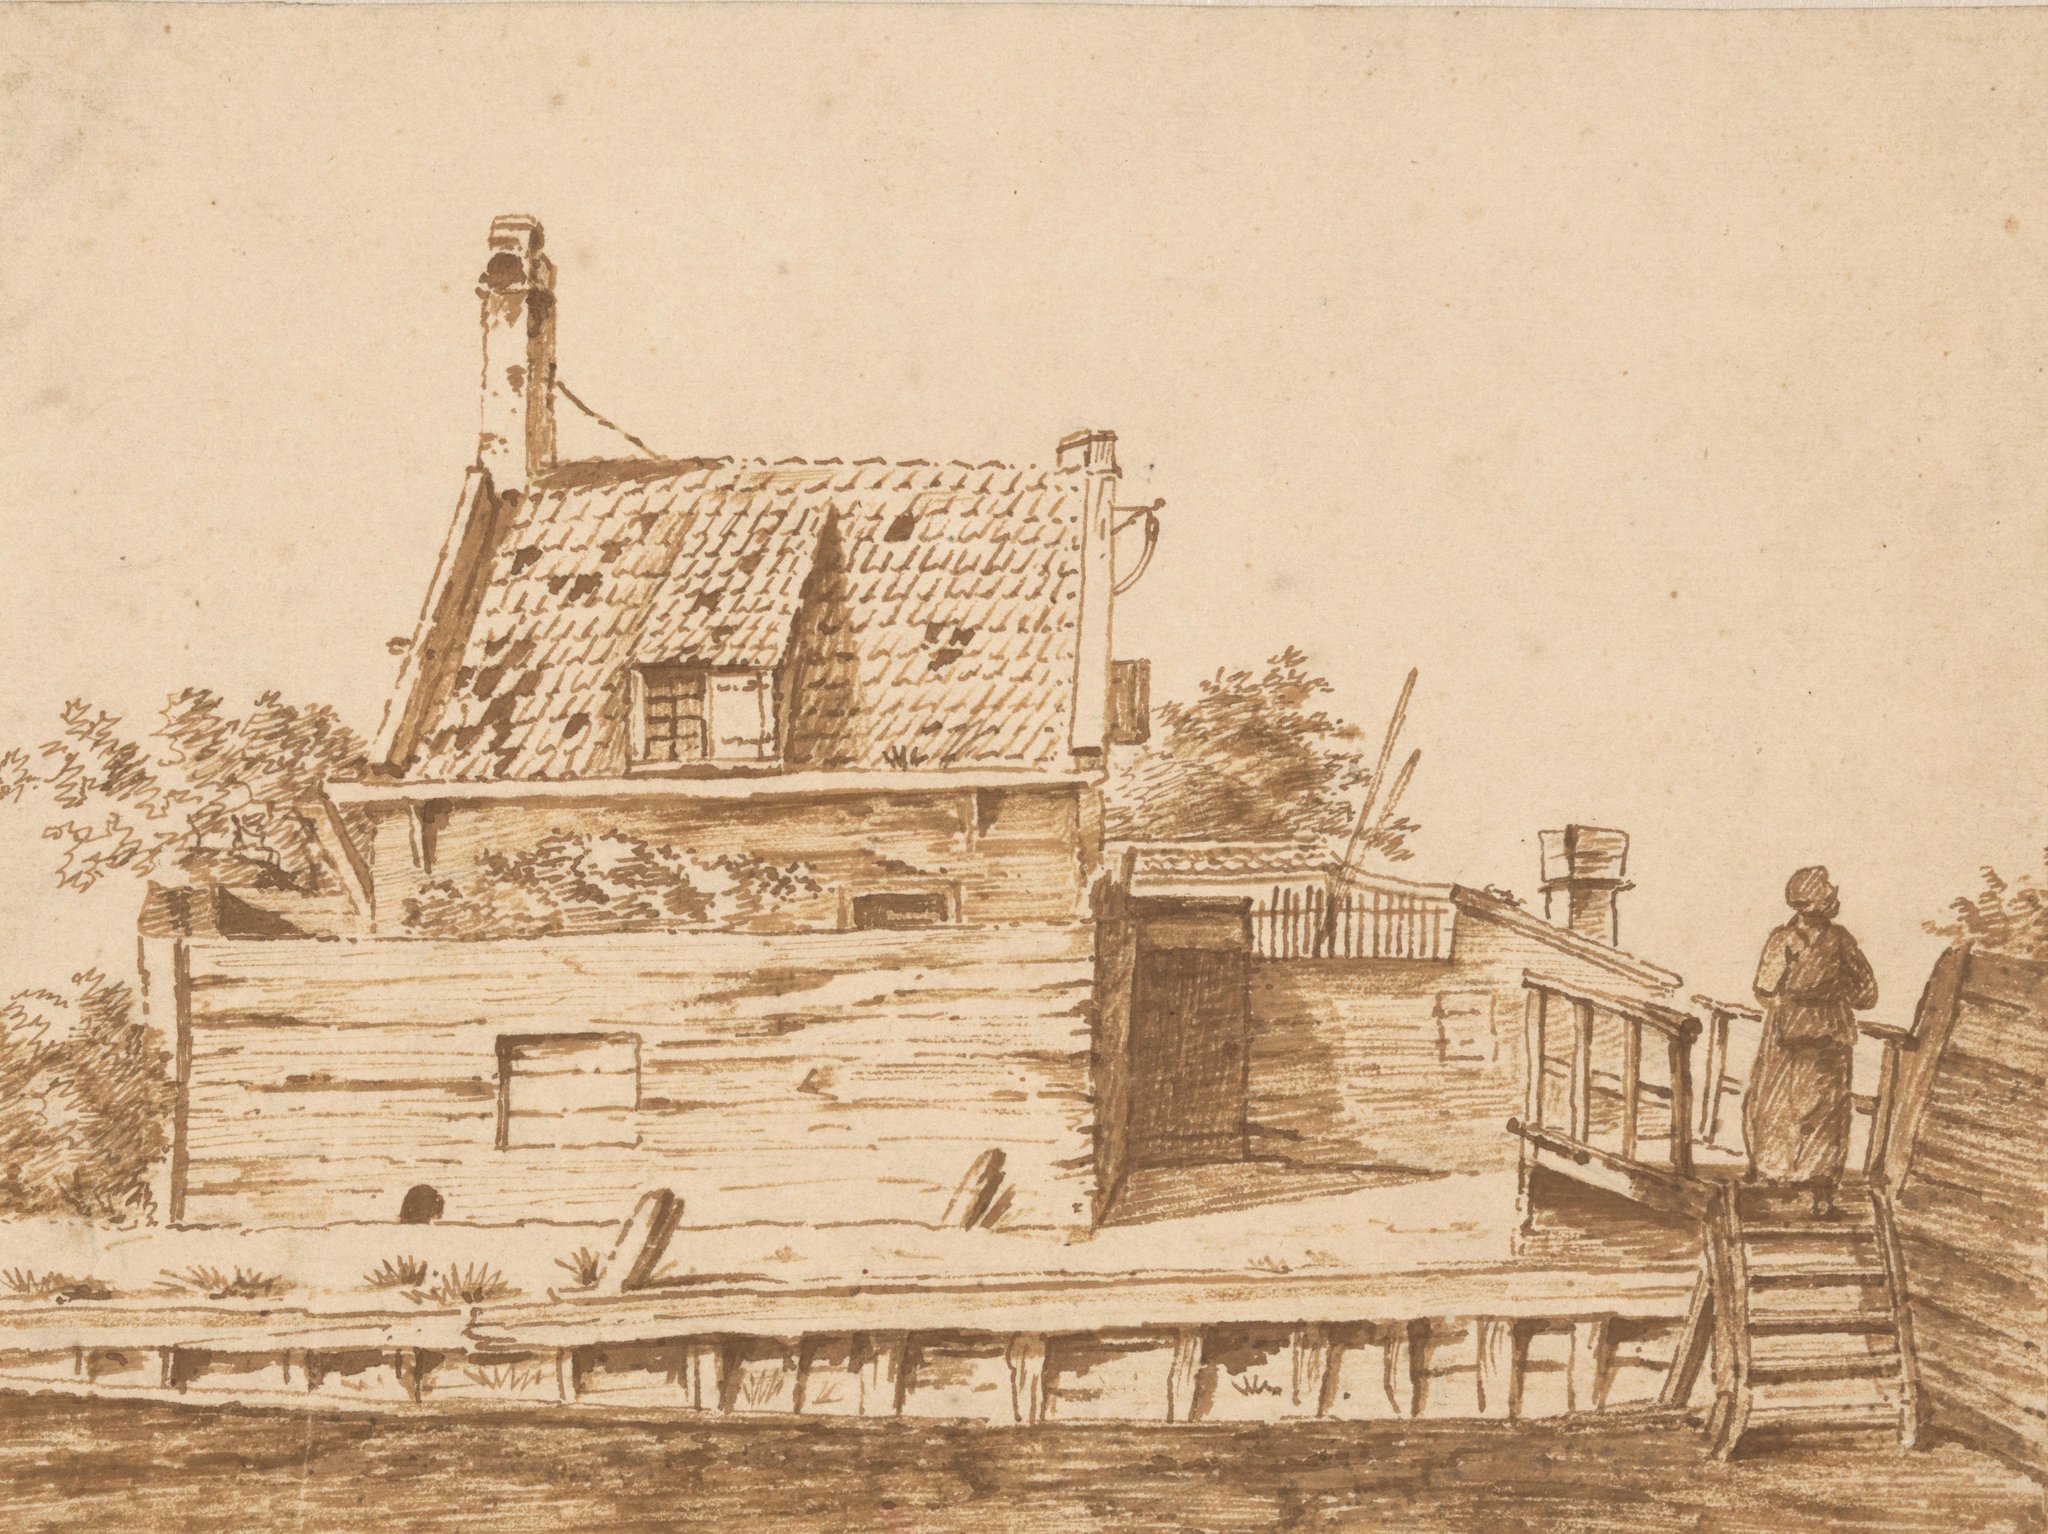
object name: drawing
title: Huis met houten omheining aan het water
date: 1700-1799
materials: ink, paper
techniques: brush, pen